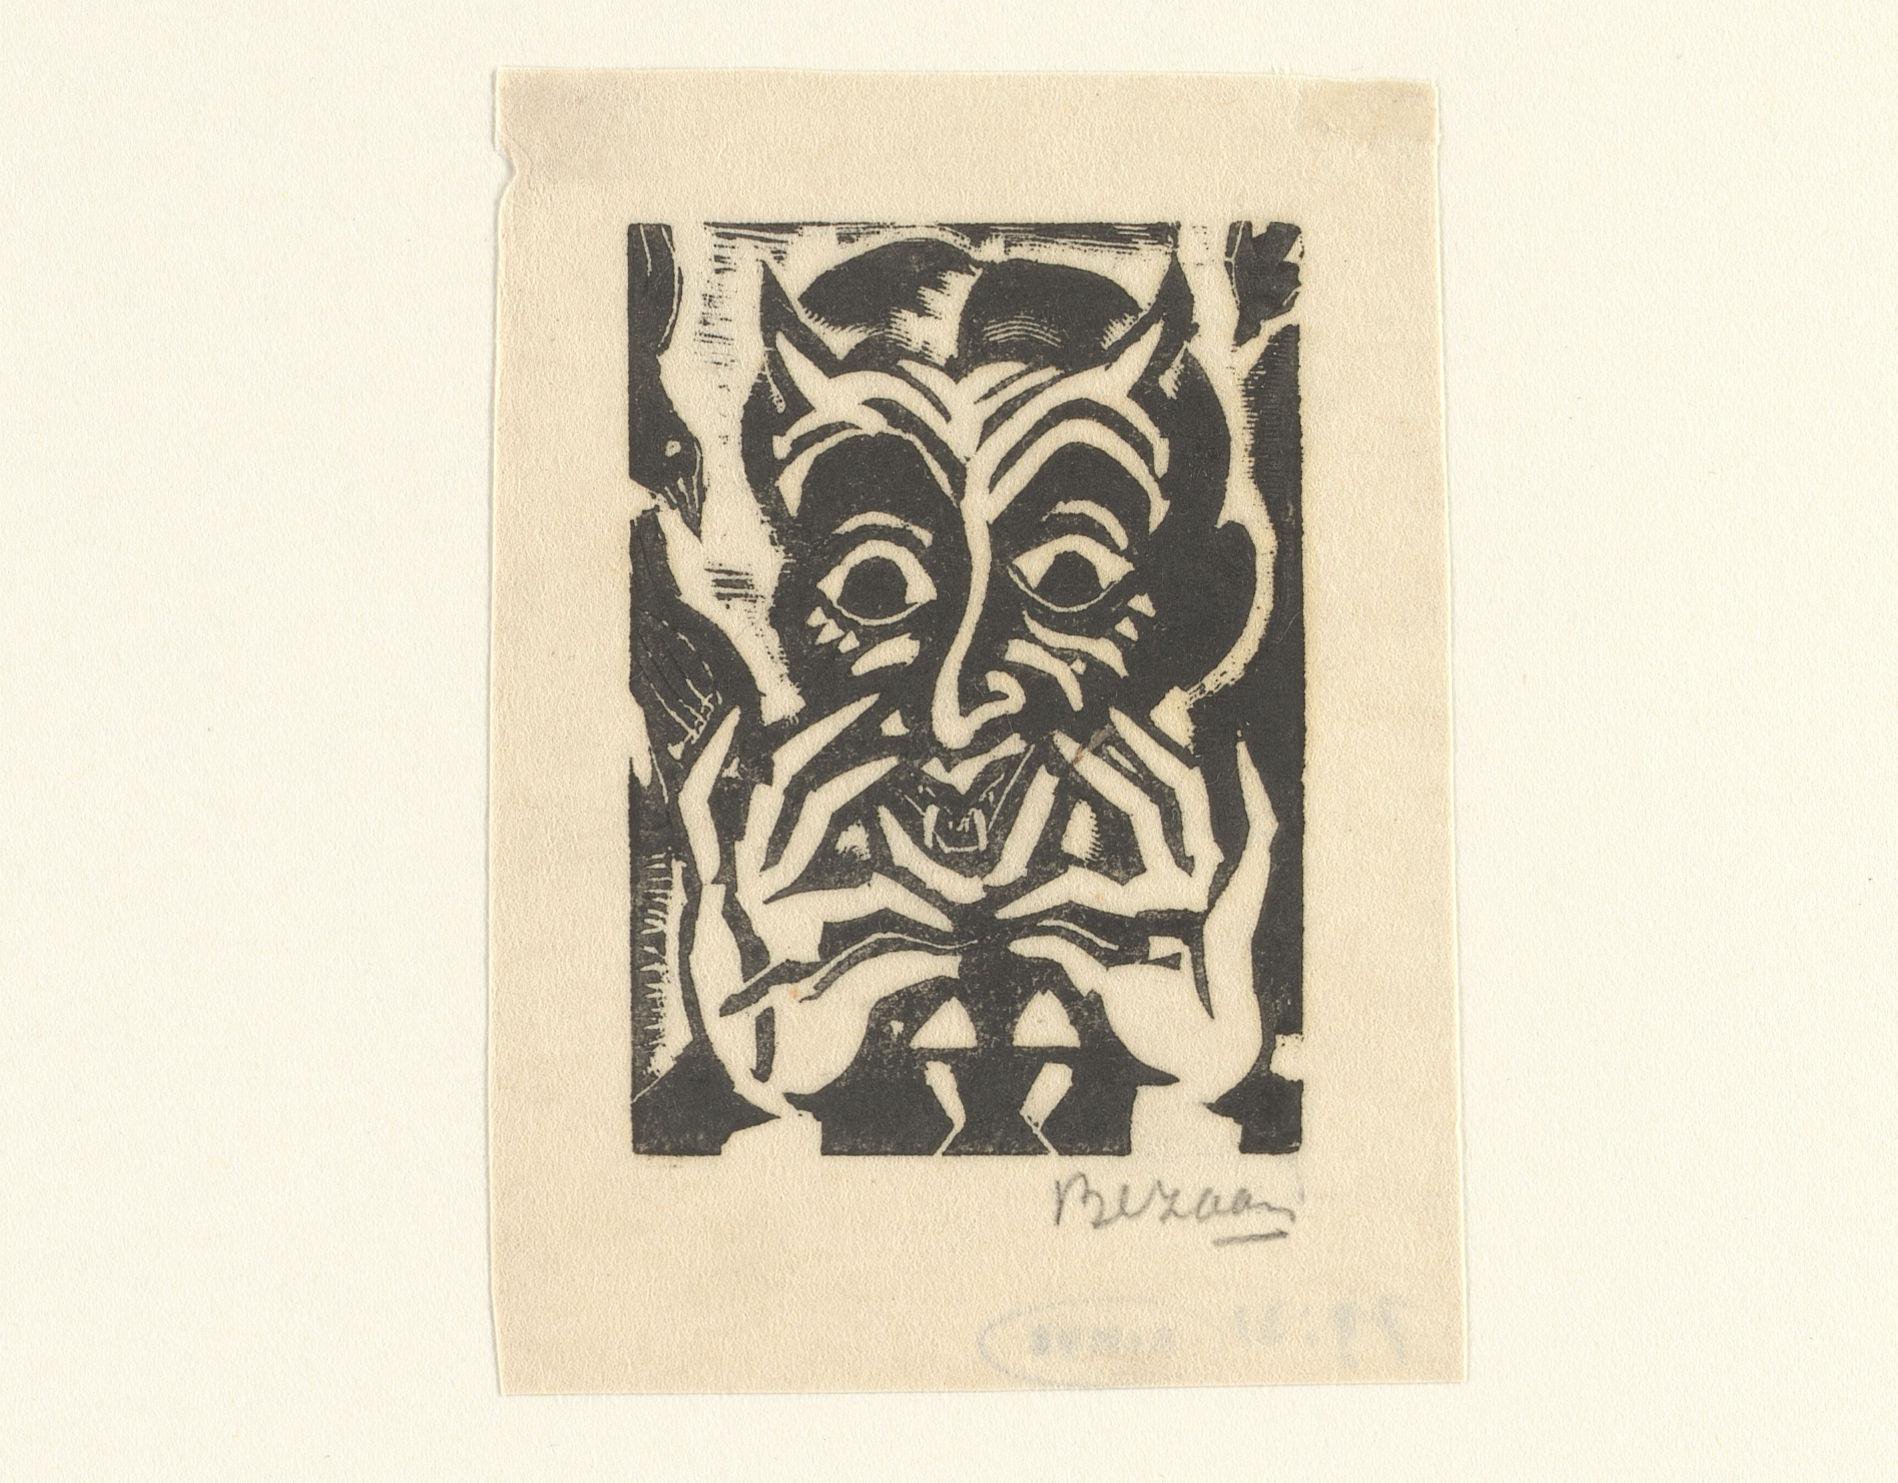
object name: print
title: Duivelsschool I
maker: jo bezaan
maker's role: draughtsman, print maker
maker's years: 1894-1952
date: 1946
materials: paper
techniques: woodcut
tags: human-shaped devil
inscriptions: collector's mark: Lugt 2228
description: Deze prent werd gemaakt als illustratie bij 'Het boek van Marc' door Jac. van Hattum. Dit werk is echter nooit als zodanig uitgegeven.